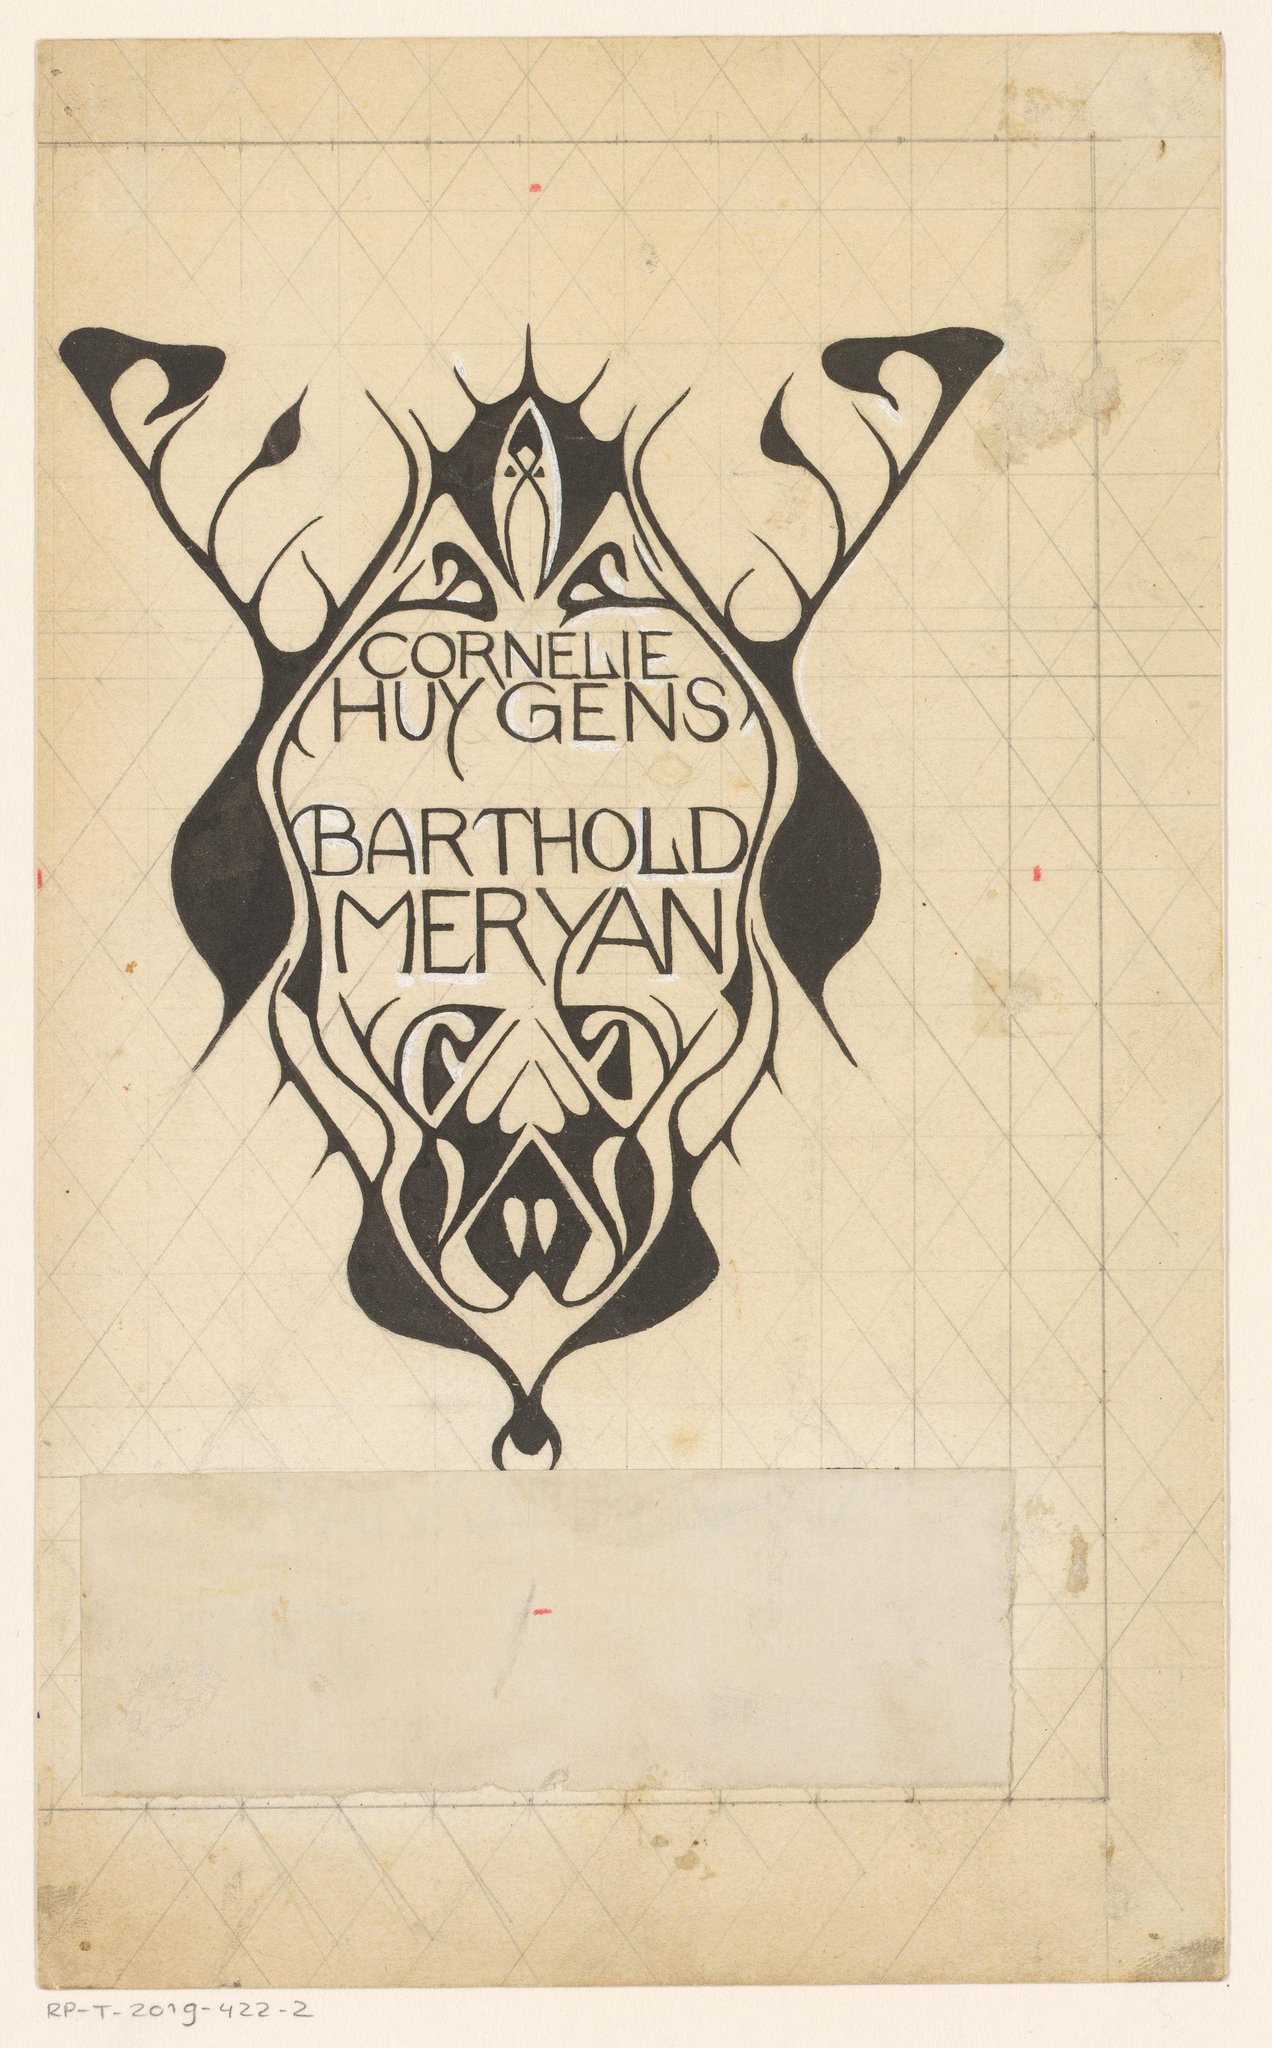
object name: drawing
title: Bandontwerp voor: Cornélie Huygens, Barthold Meryan, 1899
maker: richard nicolaüs roland holst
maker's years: 1868-1938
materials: paint, ink, paper, pencil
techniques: brush, pen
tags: ornaments ~ art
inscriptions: collector's mark: Lugt 2228, :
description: Bandontwerp voor: Huygens, Cornélie. Barthold Meryan. Amsterdam: Van Kampen, 1899.